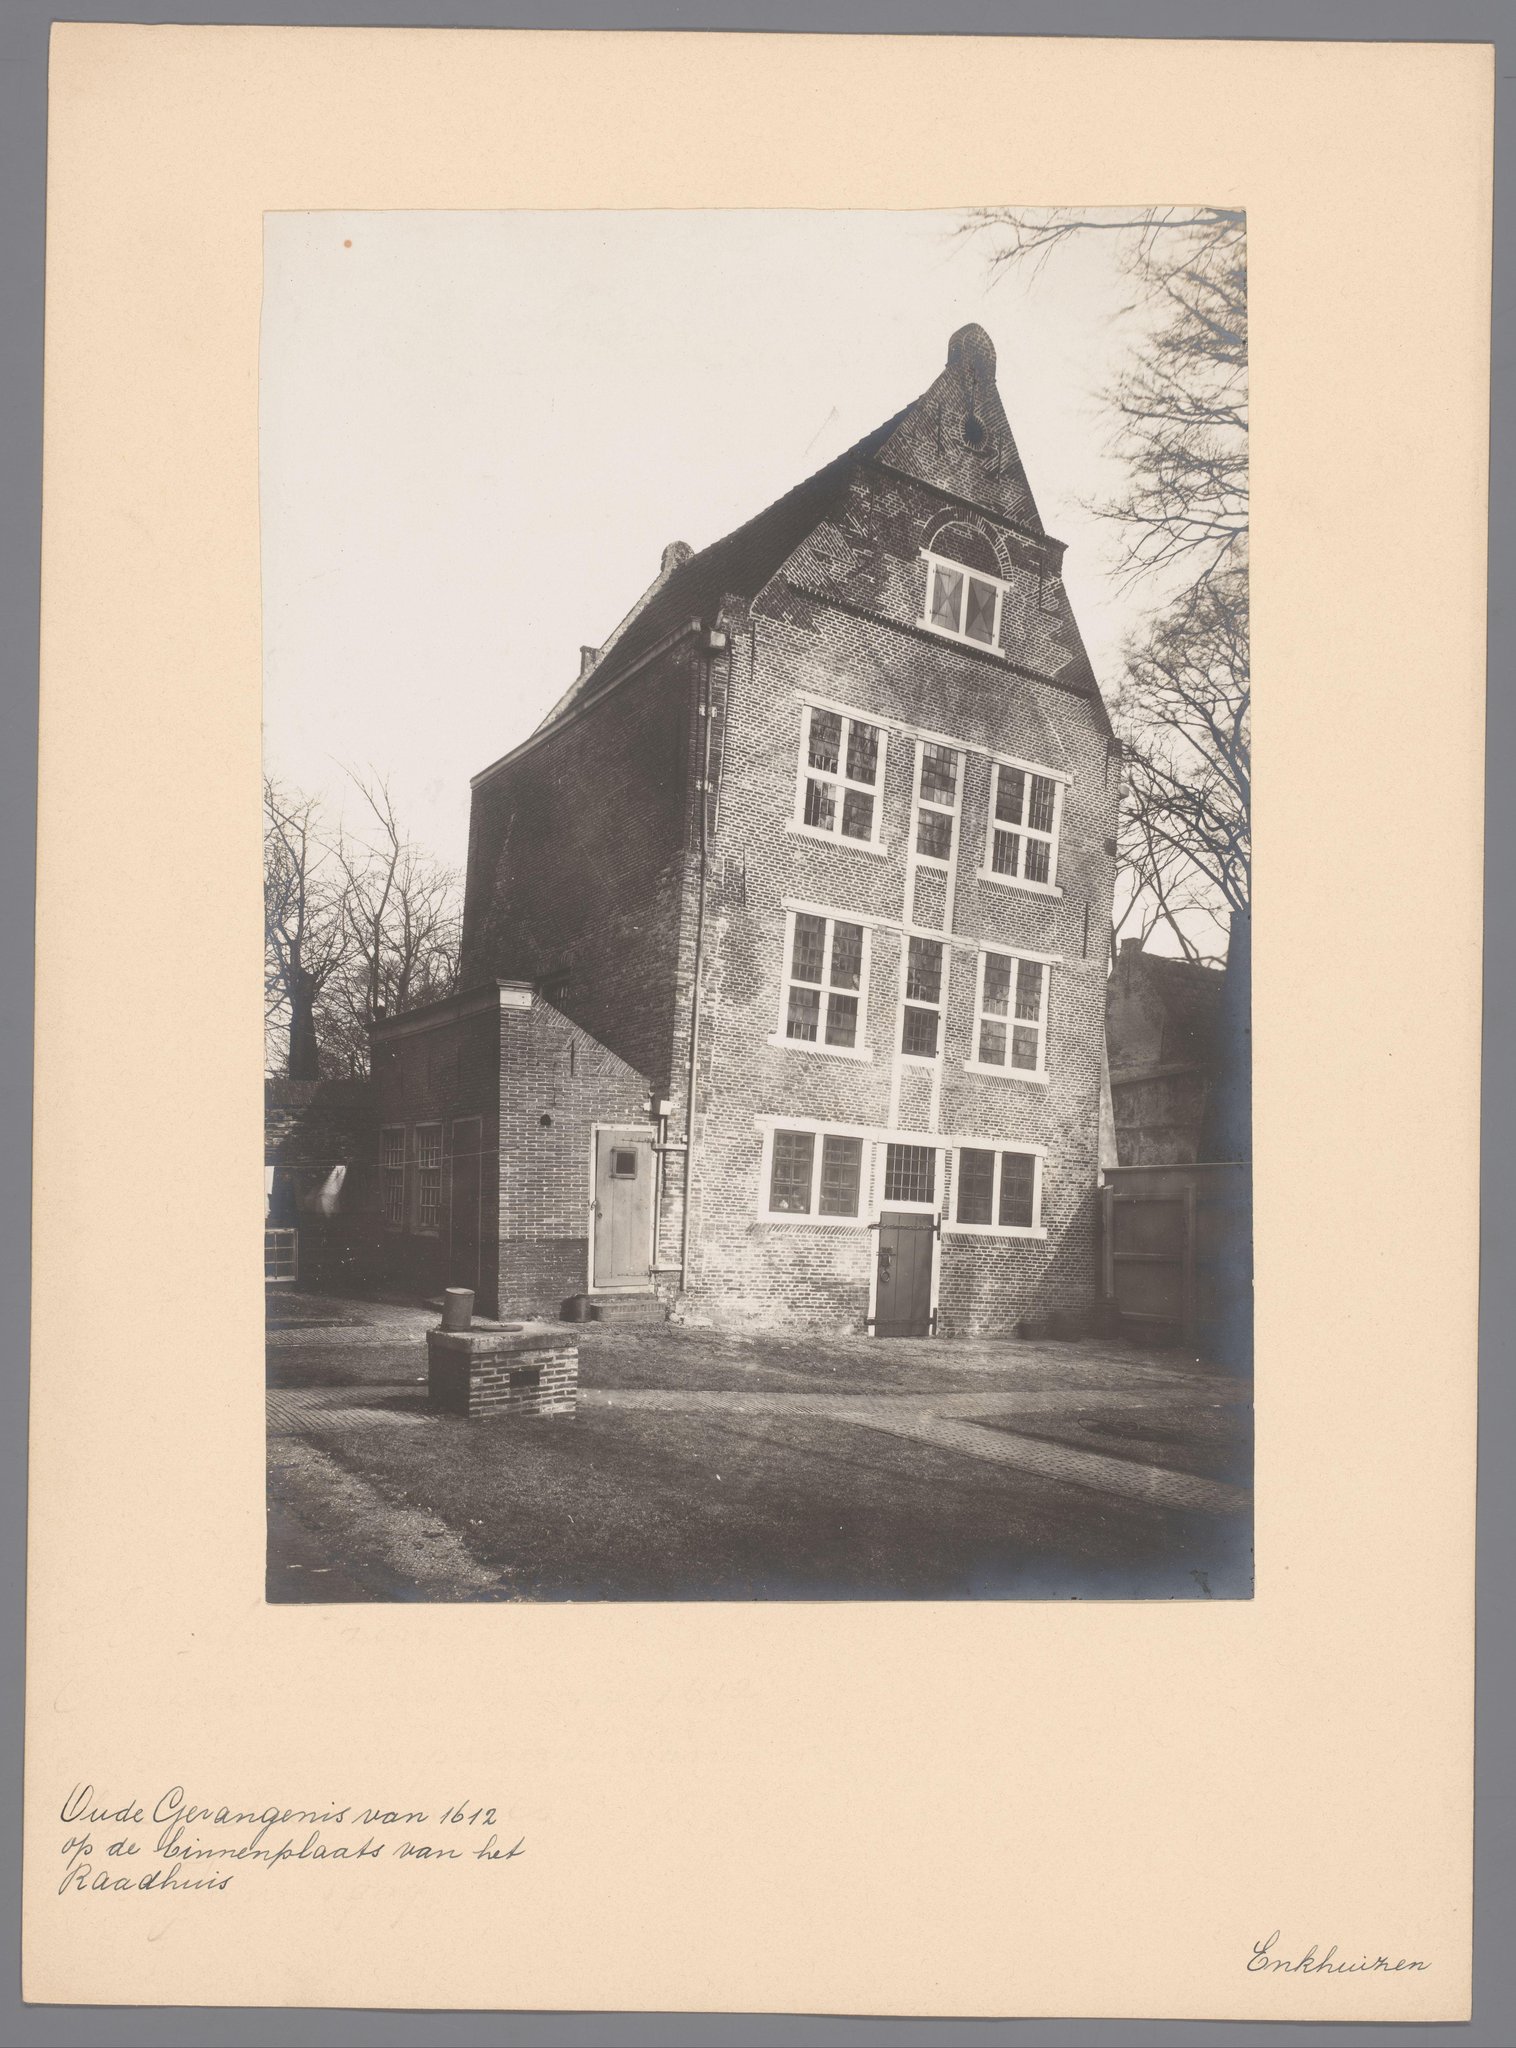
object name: photograph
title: Oude Gevangenis op de binnenplaats van het Raadhuis te Enkhuizen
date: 1900-1920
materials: cardboard, photographic support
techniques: gelatin silver print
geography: enkhuizen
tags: prison, jail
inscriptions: annotation: ‘Oude gevangenis van 1612 op de binnenplaats van het Raadhuis/ Enkhuizen’